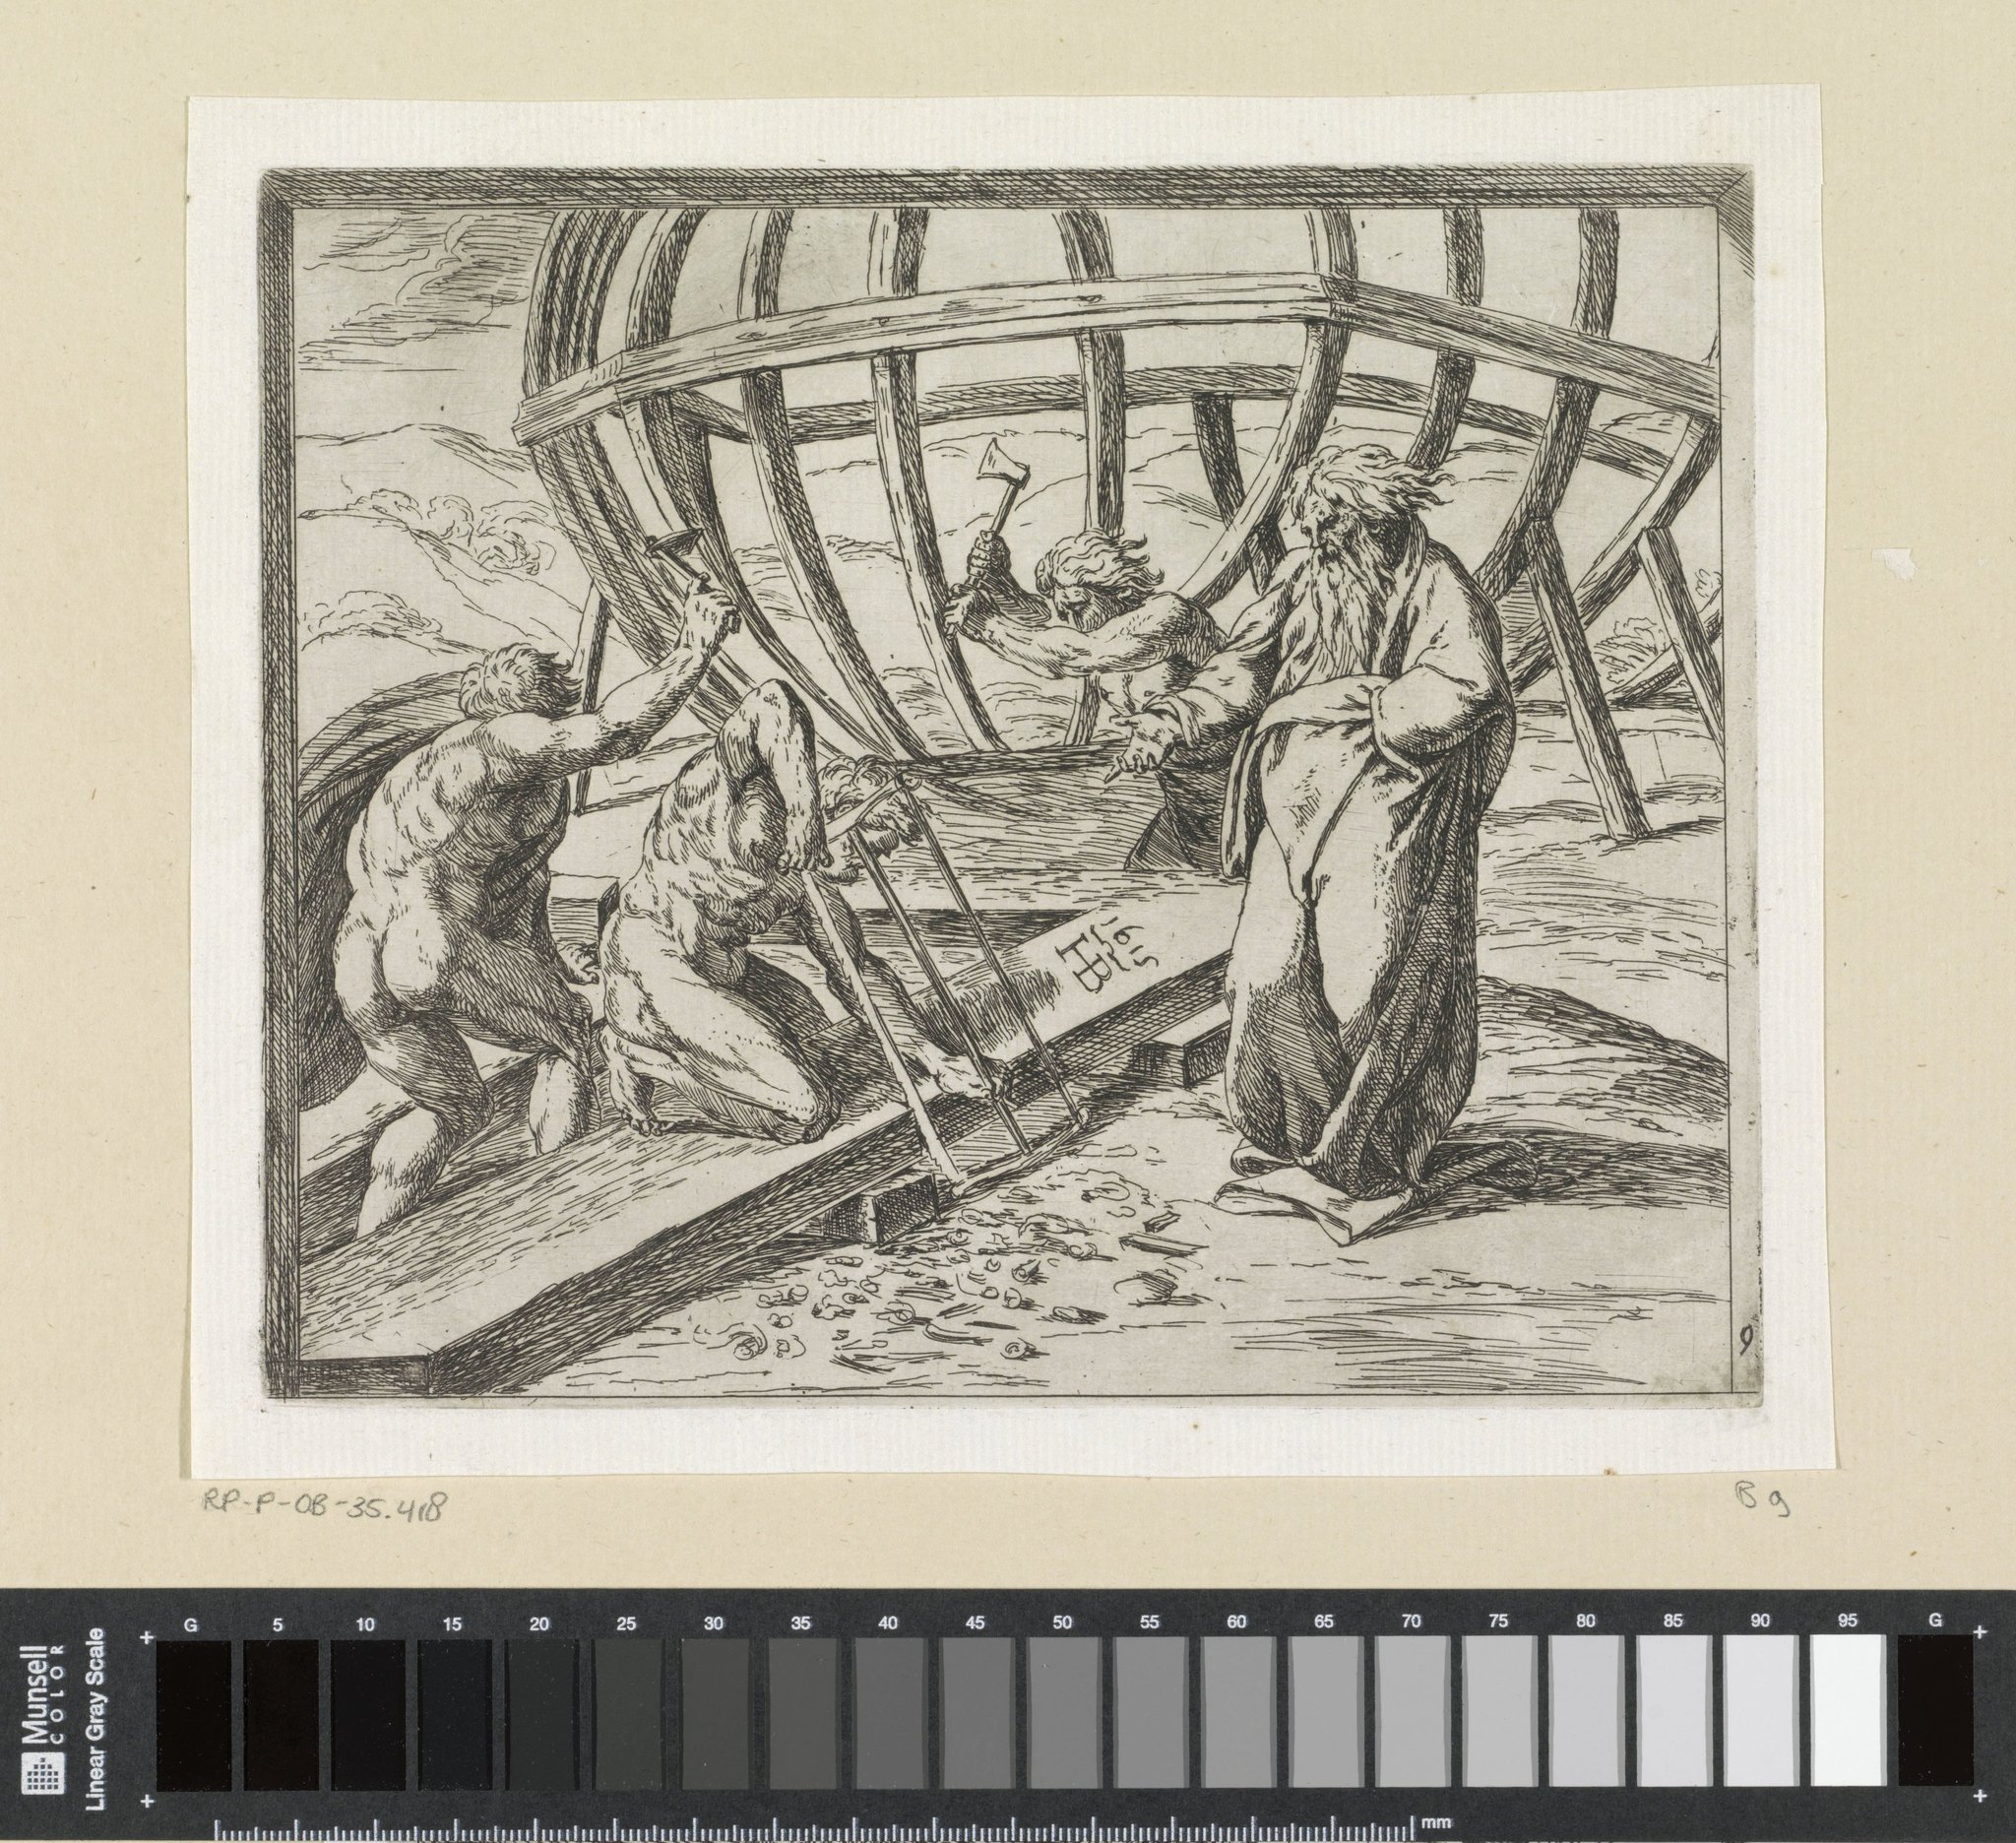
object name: print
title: Schilderingen in de Loggia van Rafaël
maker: orazio borgianni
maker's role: print maker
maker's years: 1578-1616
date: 1615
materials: paper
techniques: etching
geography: italy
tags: the building of the ark, and the embarkation (genesis 7:5-9)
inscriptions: collector's mark: Lugt 2165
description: Prent uit een reeks van 52 prenten naar schilderingen in de Loggia van Rafaël in het Vaticaan.